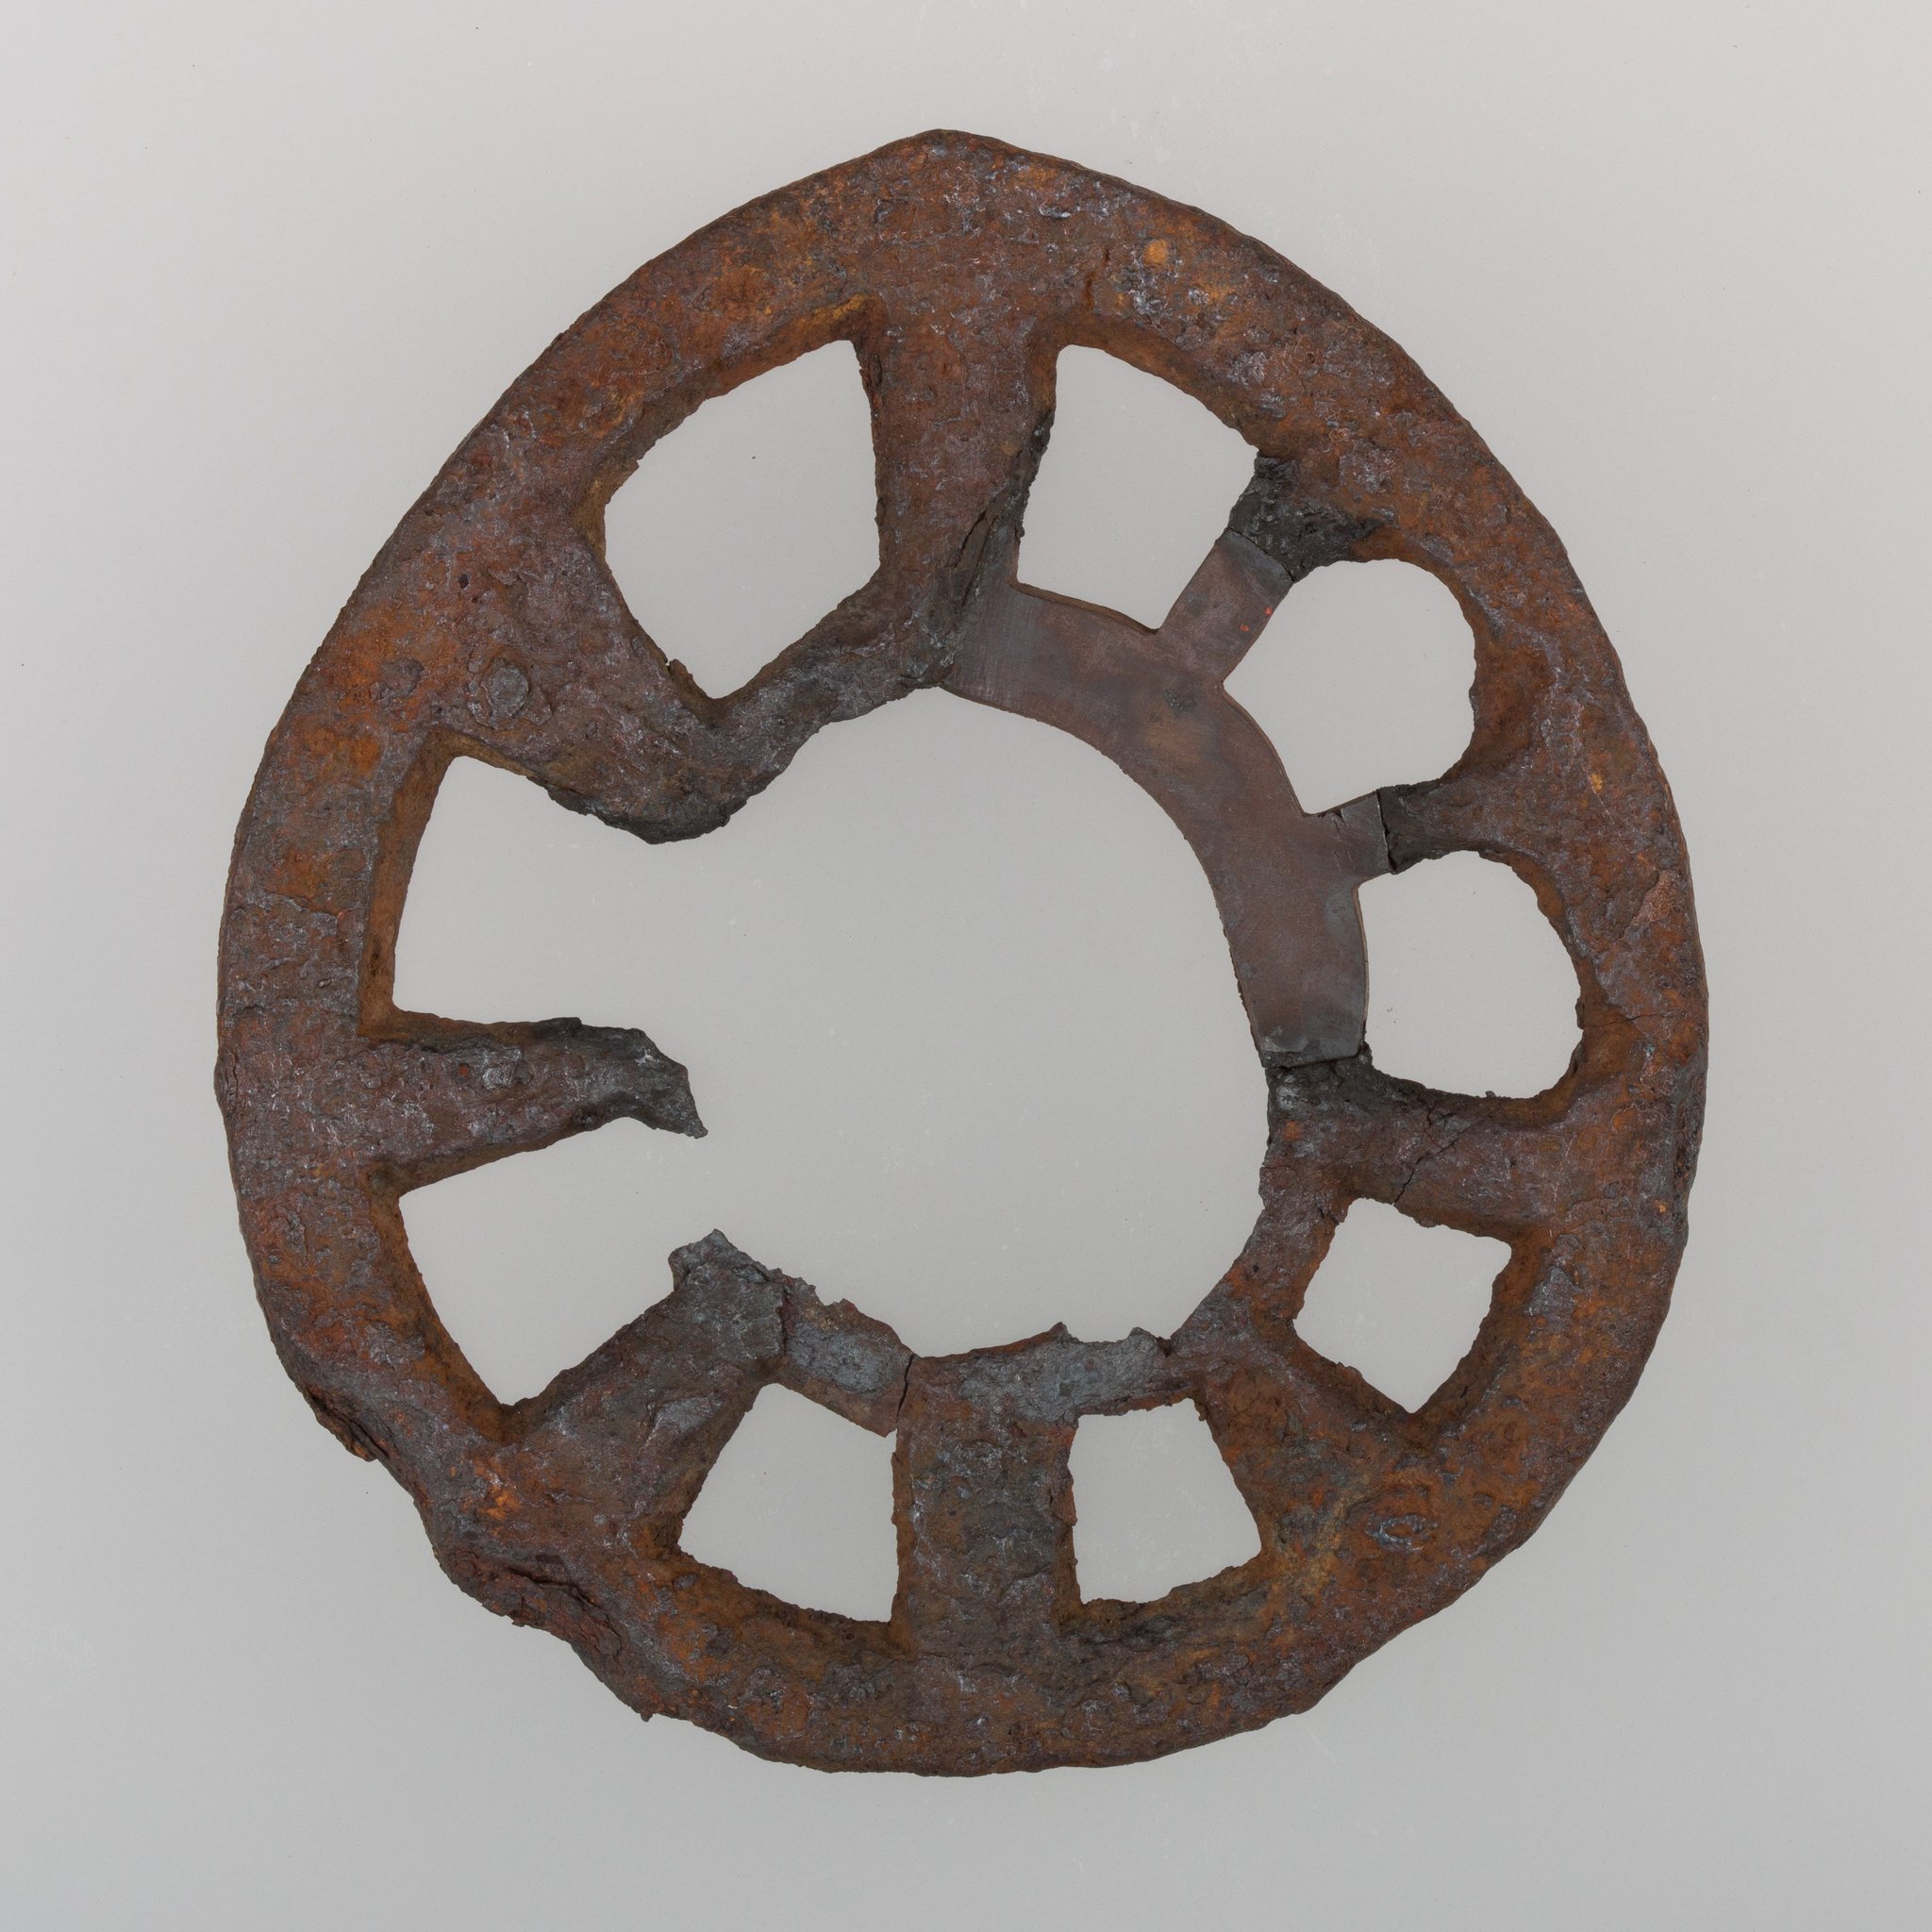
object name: sword guard tsuba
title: Sword Guard (Tsuba)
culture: japanese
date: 201-300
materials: iron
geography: japan